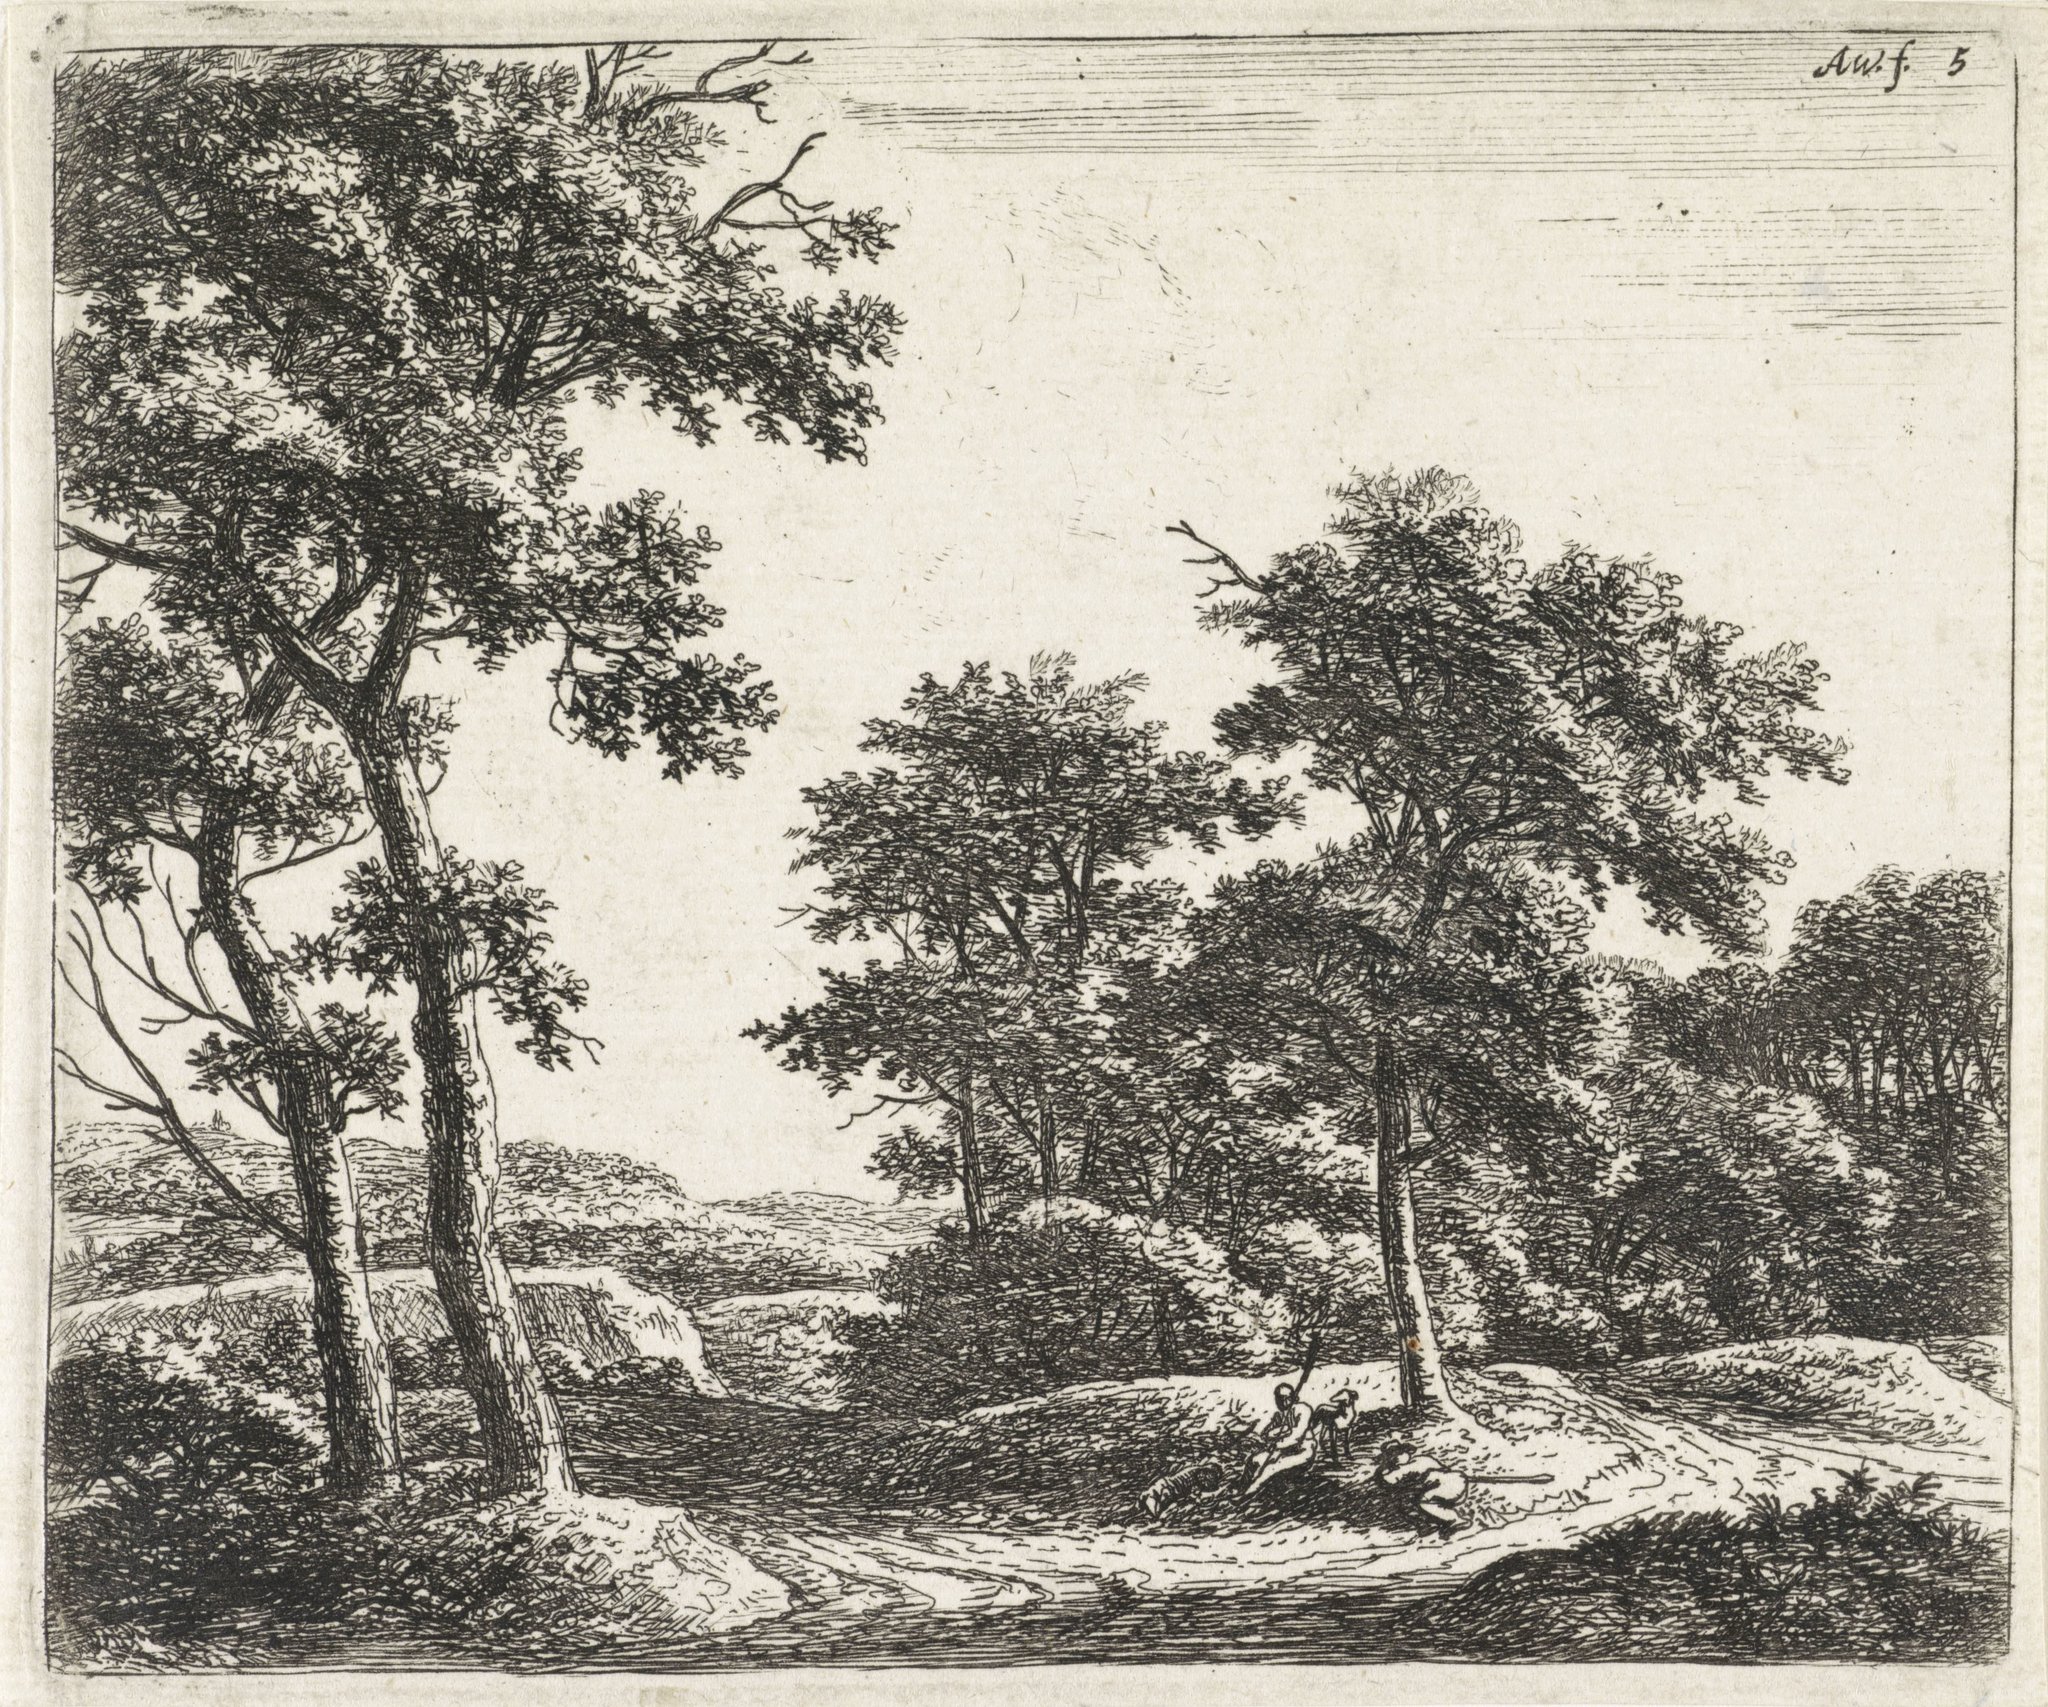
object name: print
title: Landschappen met boompartijen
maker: anthonie waterloo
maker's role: draughtsman, painter, print maker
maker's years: 1609-1690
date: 1630-1663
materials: paper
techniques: etching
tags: herding, herdsman, herdswoman, shepherd, shepherdess, cowherd, etc., forest, wood, landscapes (+ landscape with figures, staffage), resting - bb - out of doors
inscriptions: collector's mark: Lugt 2228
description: Zie Hollstein voor een volledig overzicht van de verschillende edities.